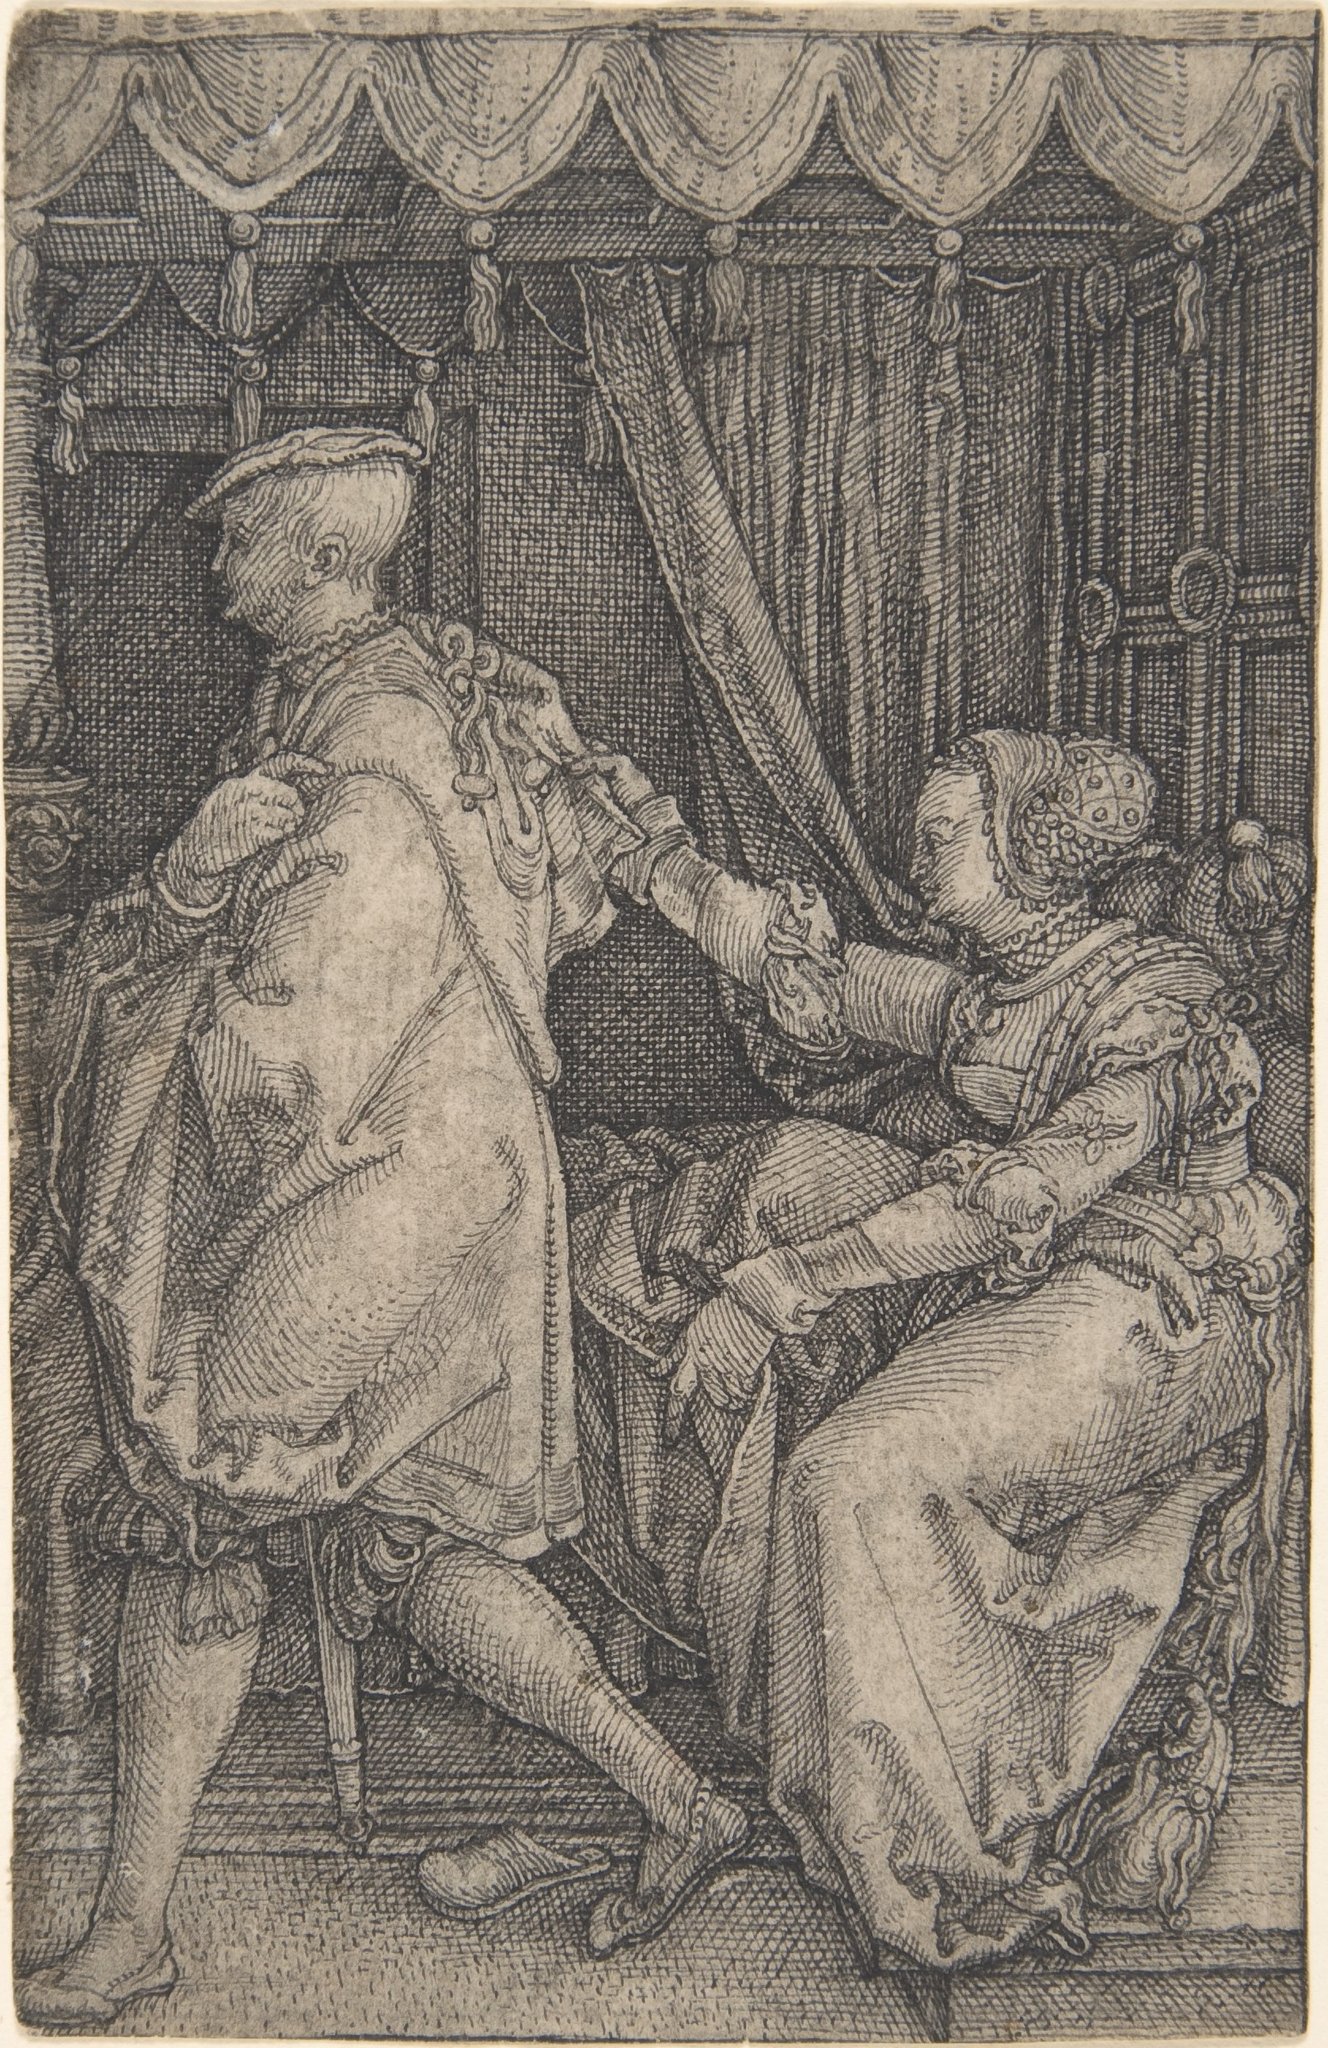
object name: drawing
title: Joseph and Potiphar's Wife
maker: heinrich aldegrever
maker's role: artist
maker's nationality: german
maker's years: 1502-1561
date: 1510-1565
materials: ink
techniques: pen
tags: men,women